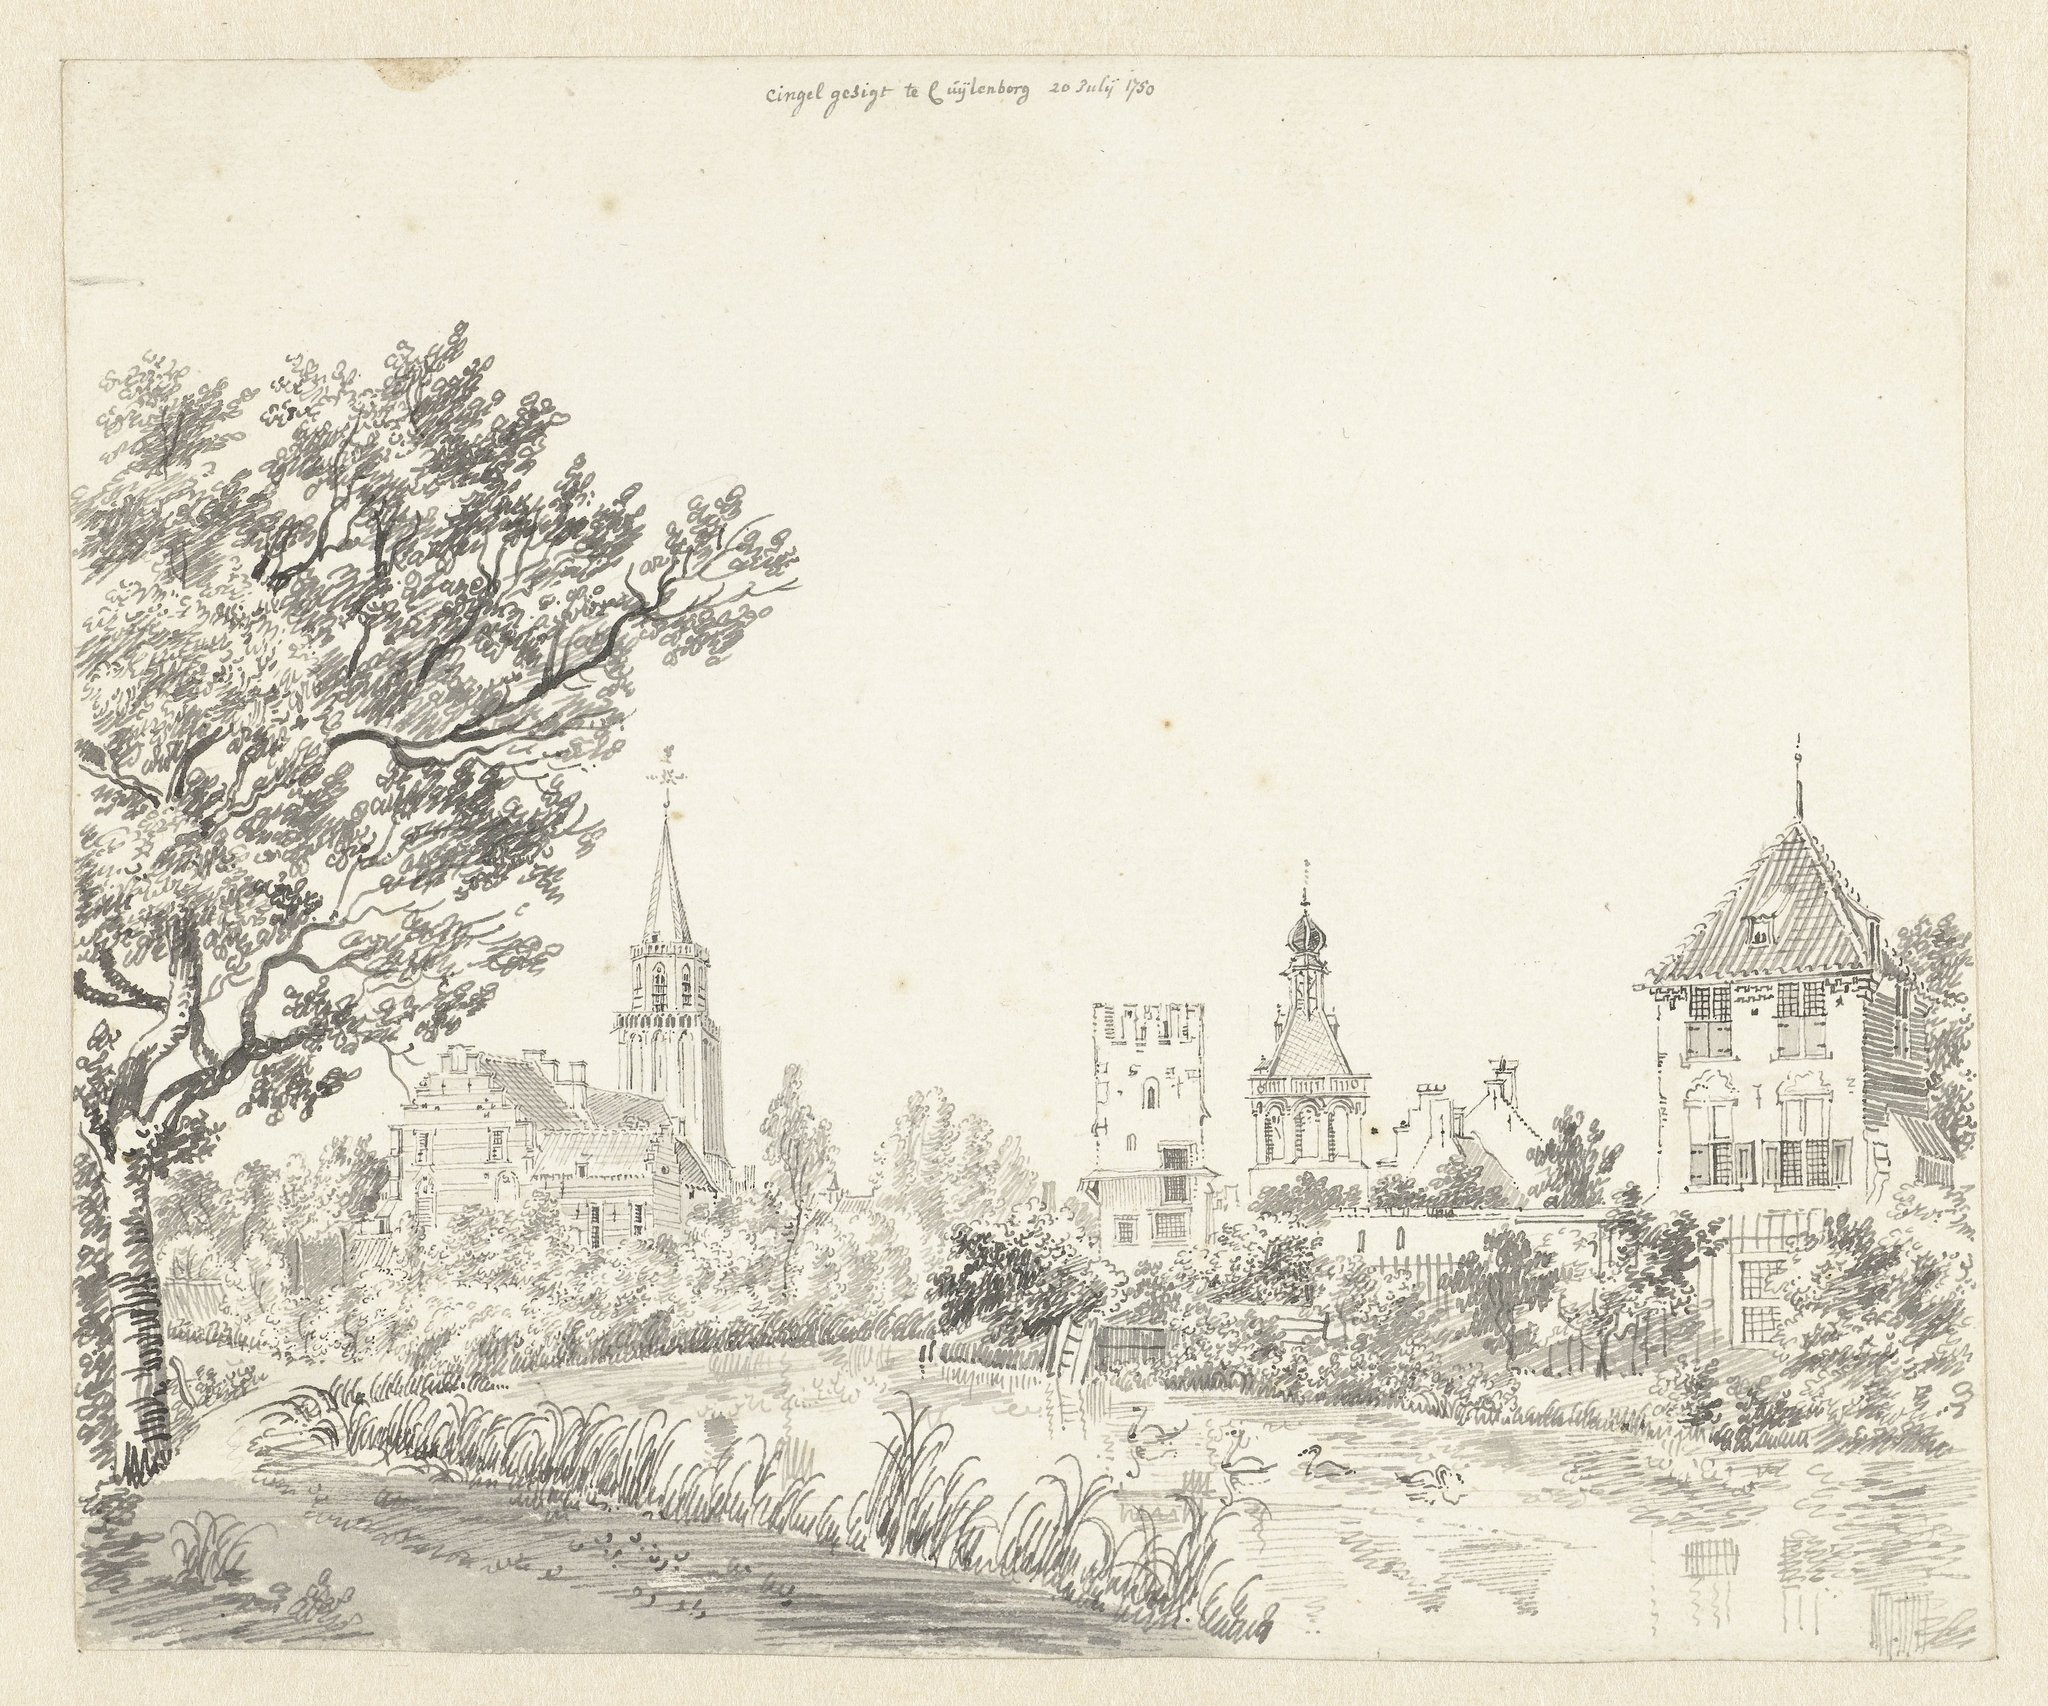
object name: drawing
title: Gezicht te Culemborg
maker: jan de beijer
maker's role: draughtsman, print maker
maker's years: 1703-1780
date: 1750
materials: ink, paper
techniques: brush, pen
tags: prospect of city, town panorama, silhouette of city